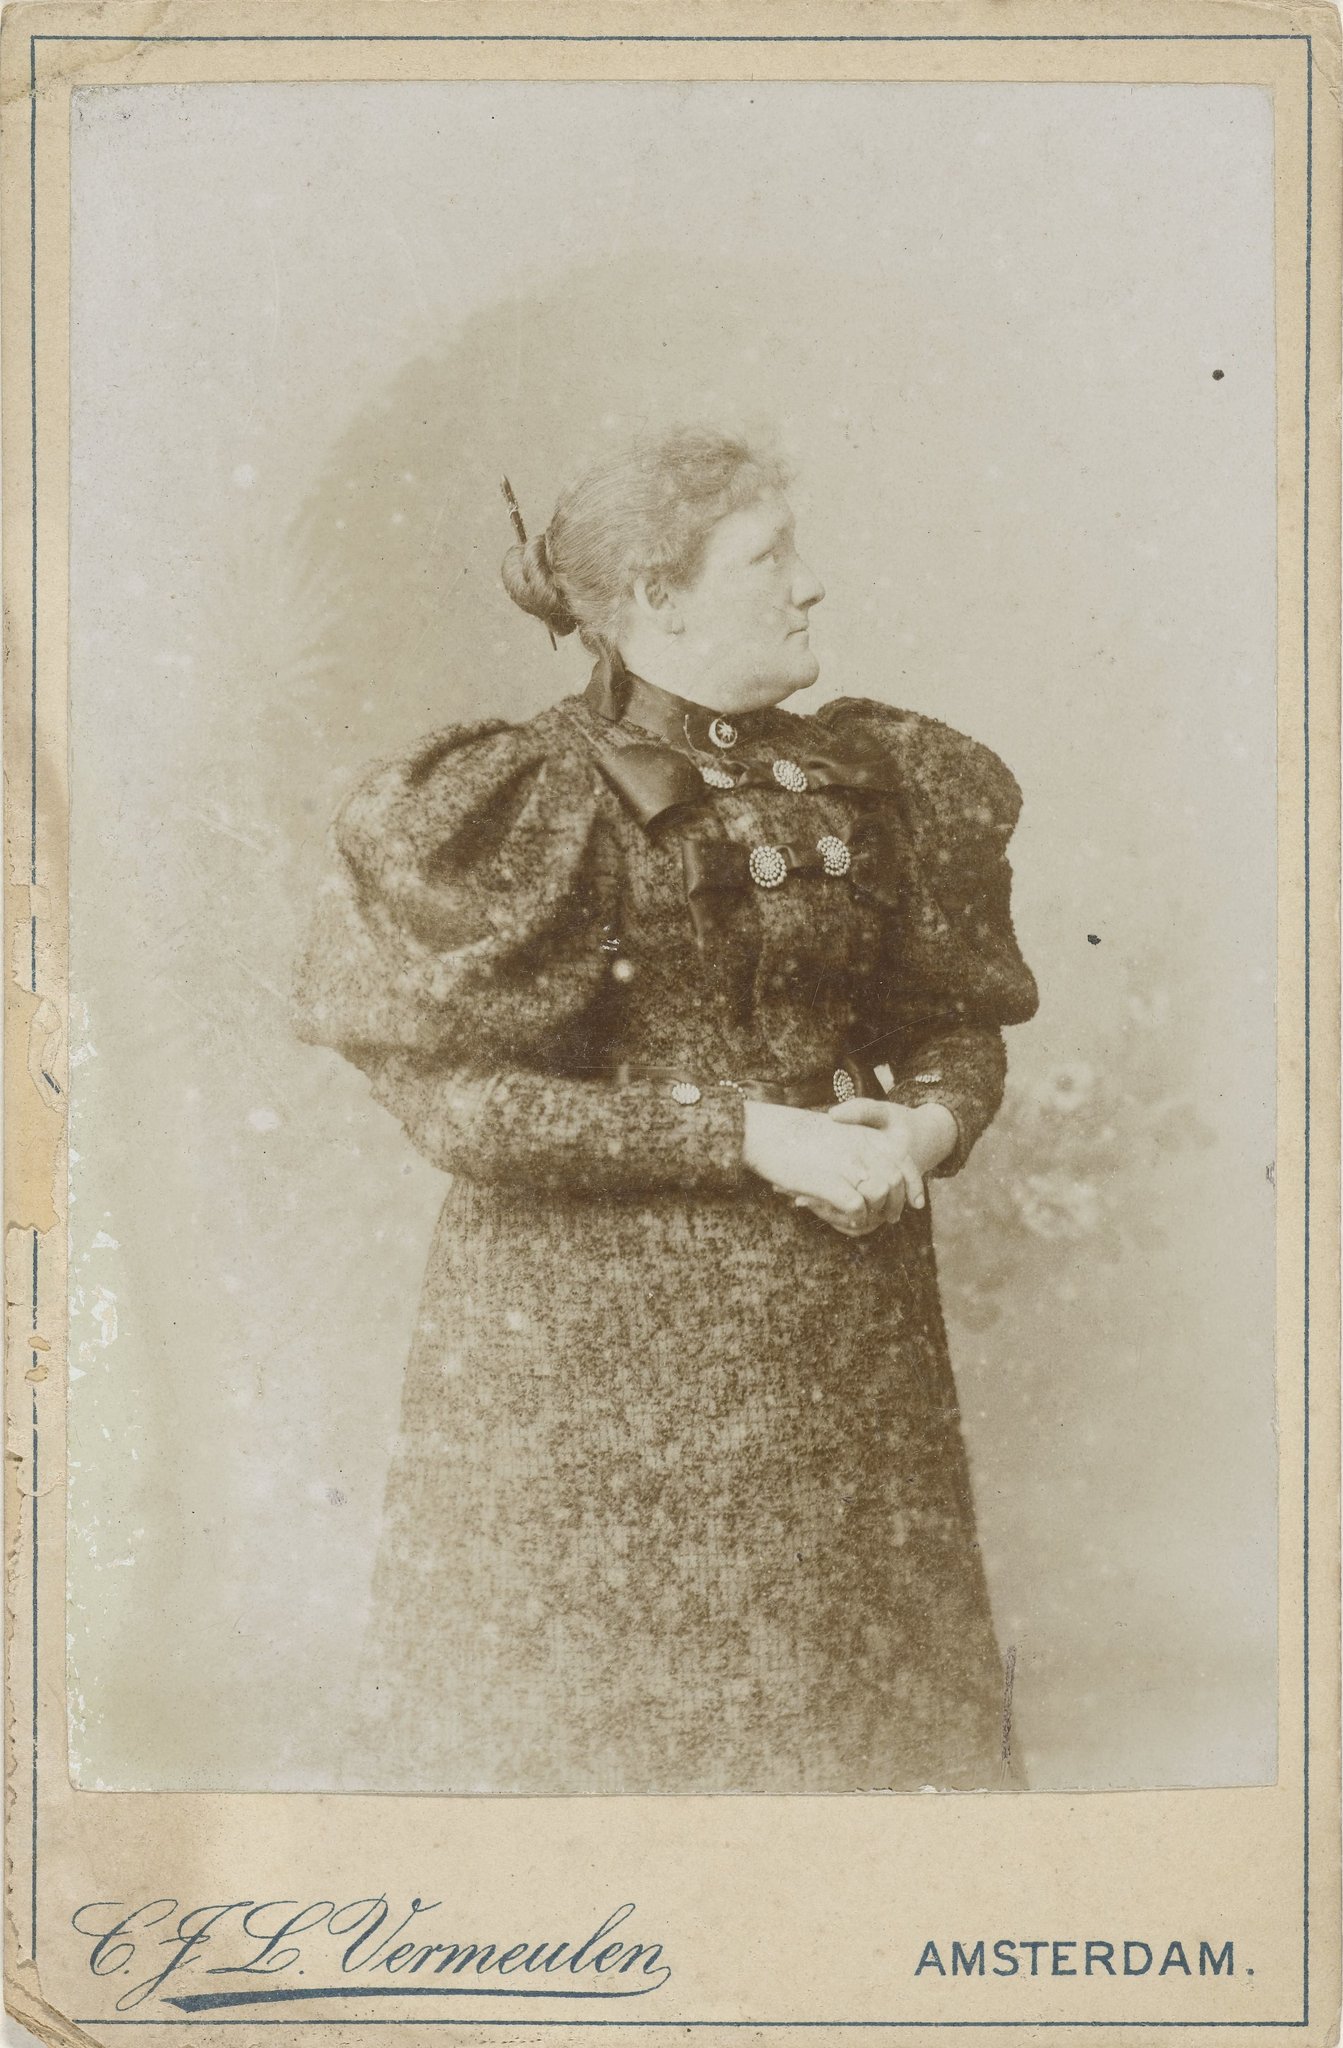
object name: photograph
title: Portret van Grietje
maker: cornelis johannes lodewicus vermeulen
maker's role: fotograaf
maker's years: 1861-1936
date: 1880-1920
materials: photographic support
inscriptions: inscription: ‘Bram V’